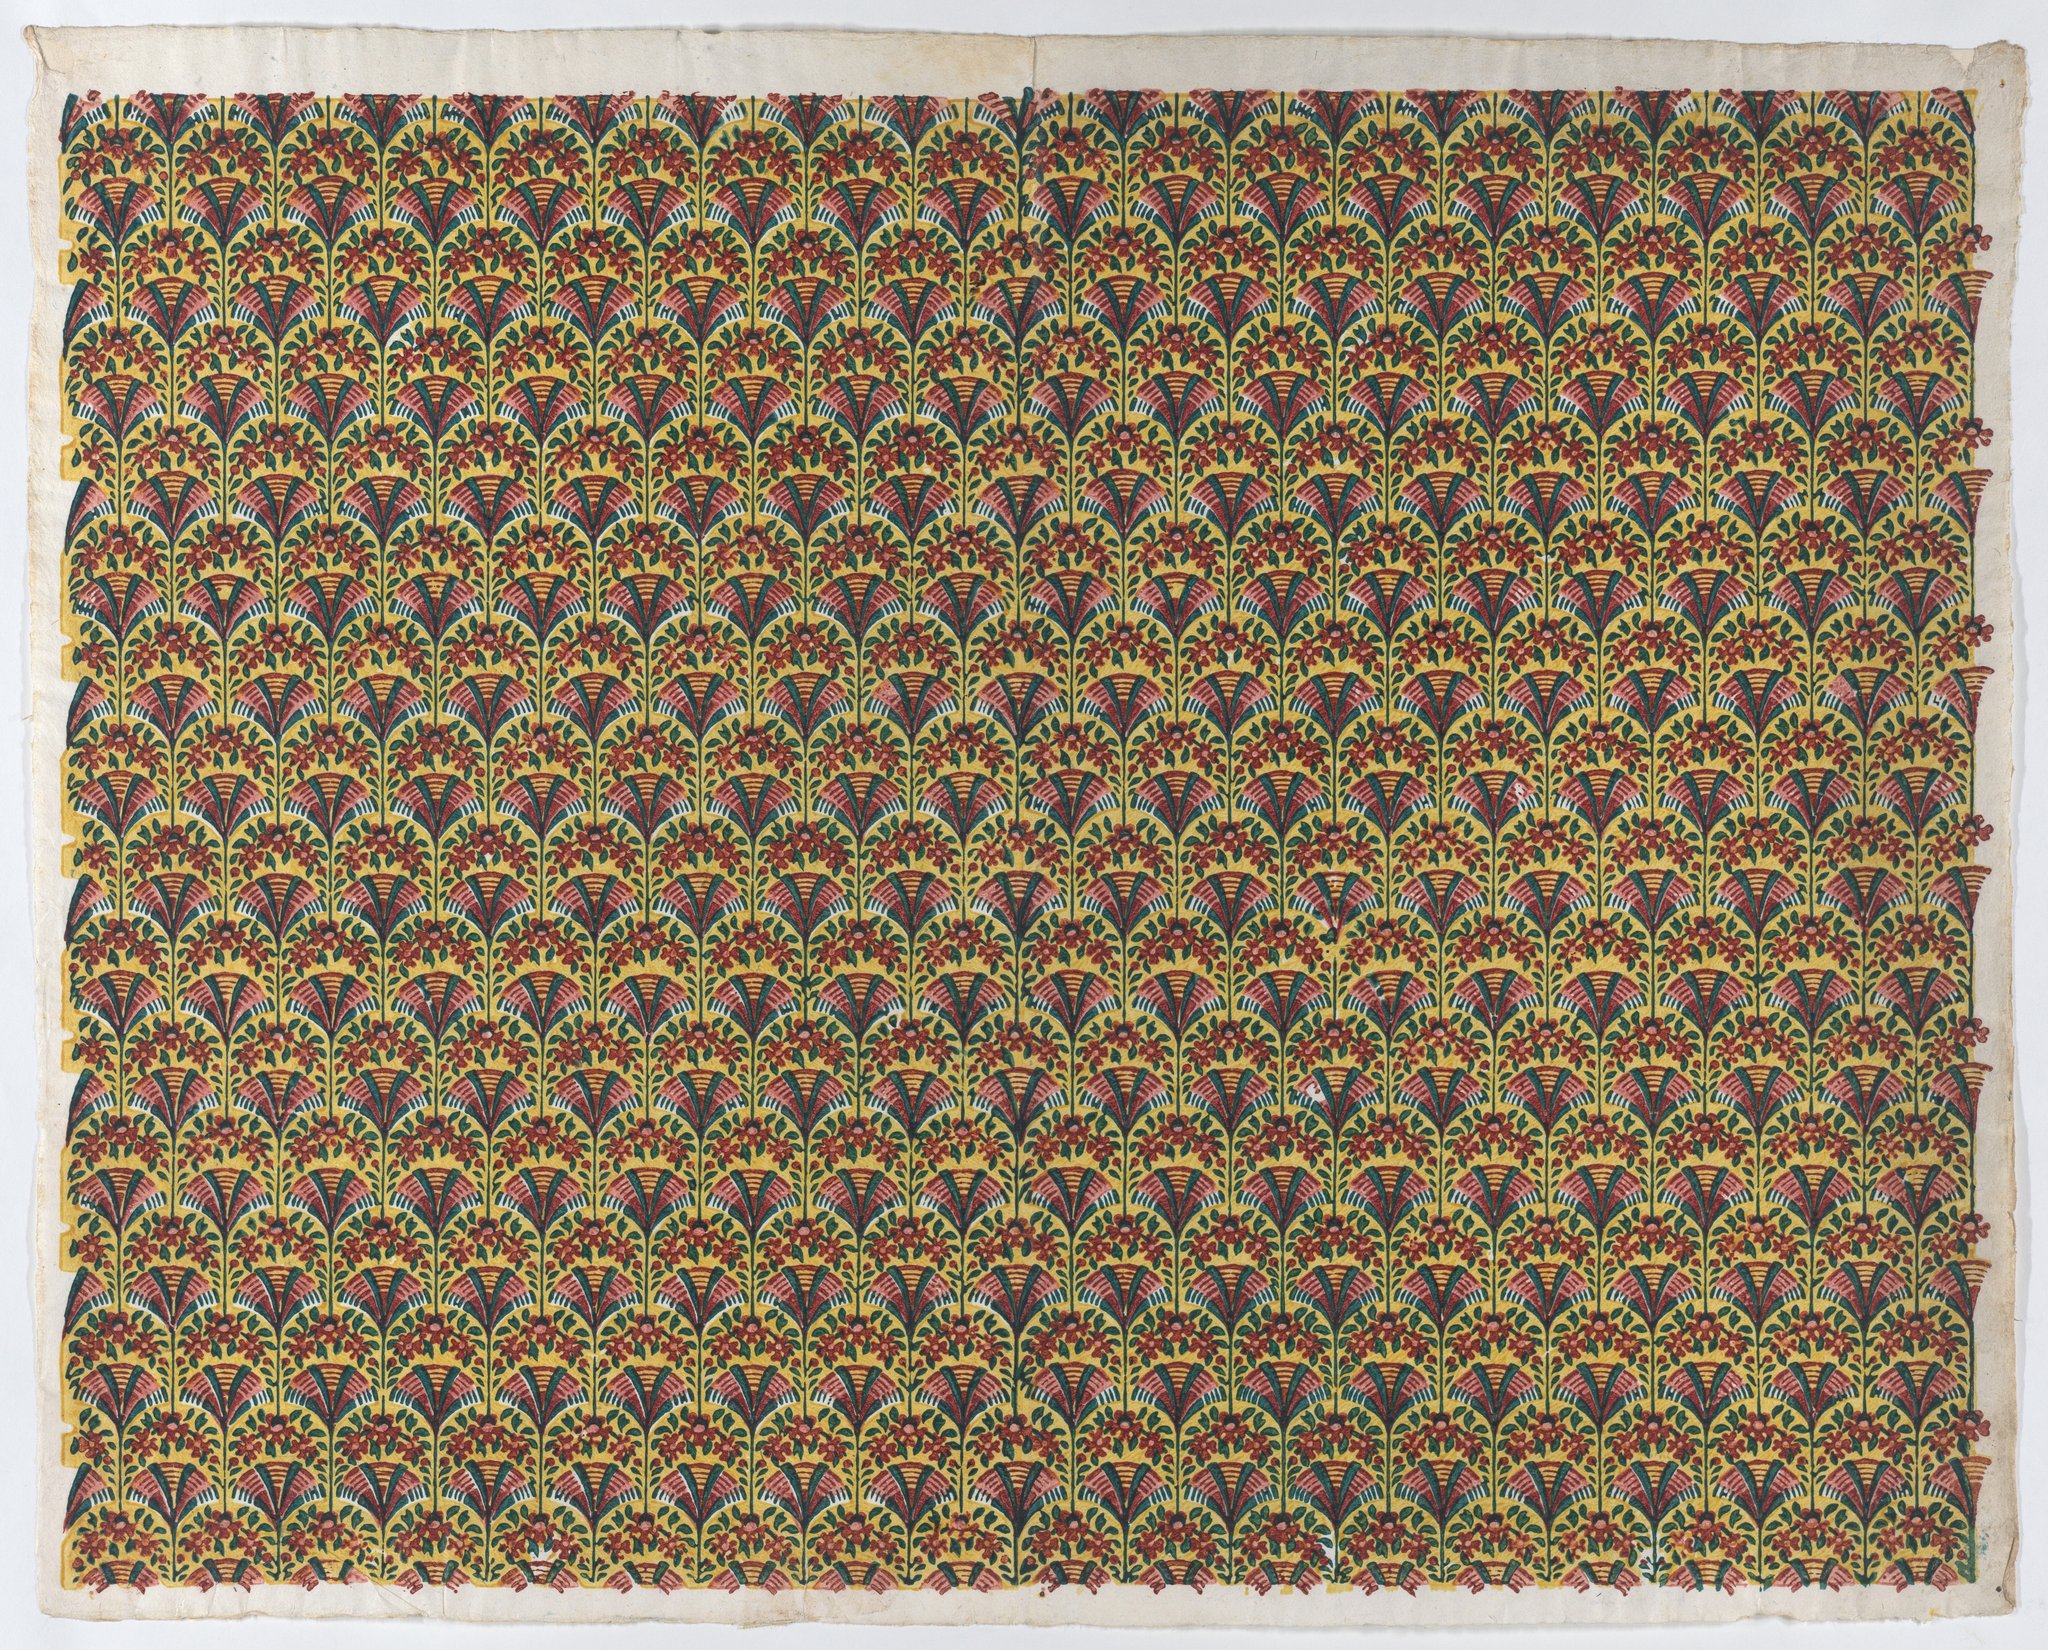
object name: print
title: Sheet with overall fan design in yellow, green, and red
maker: Anonymous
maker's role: artist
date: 1767-1866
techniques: relief print